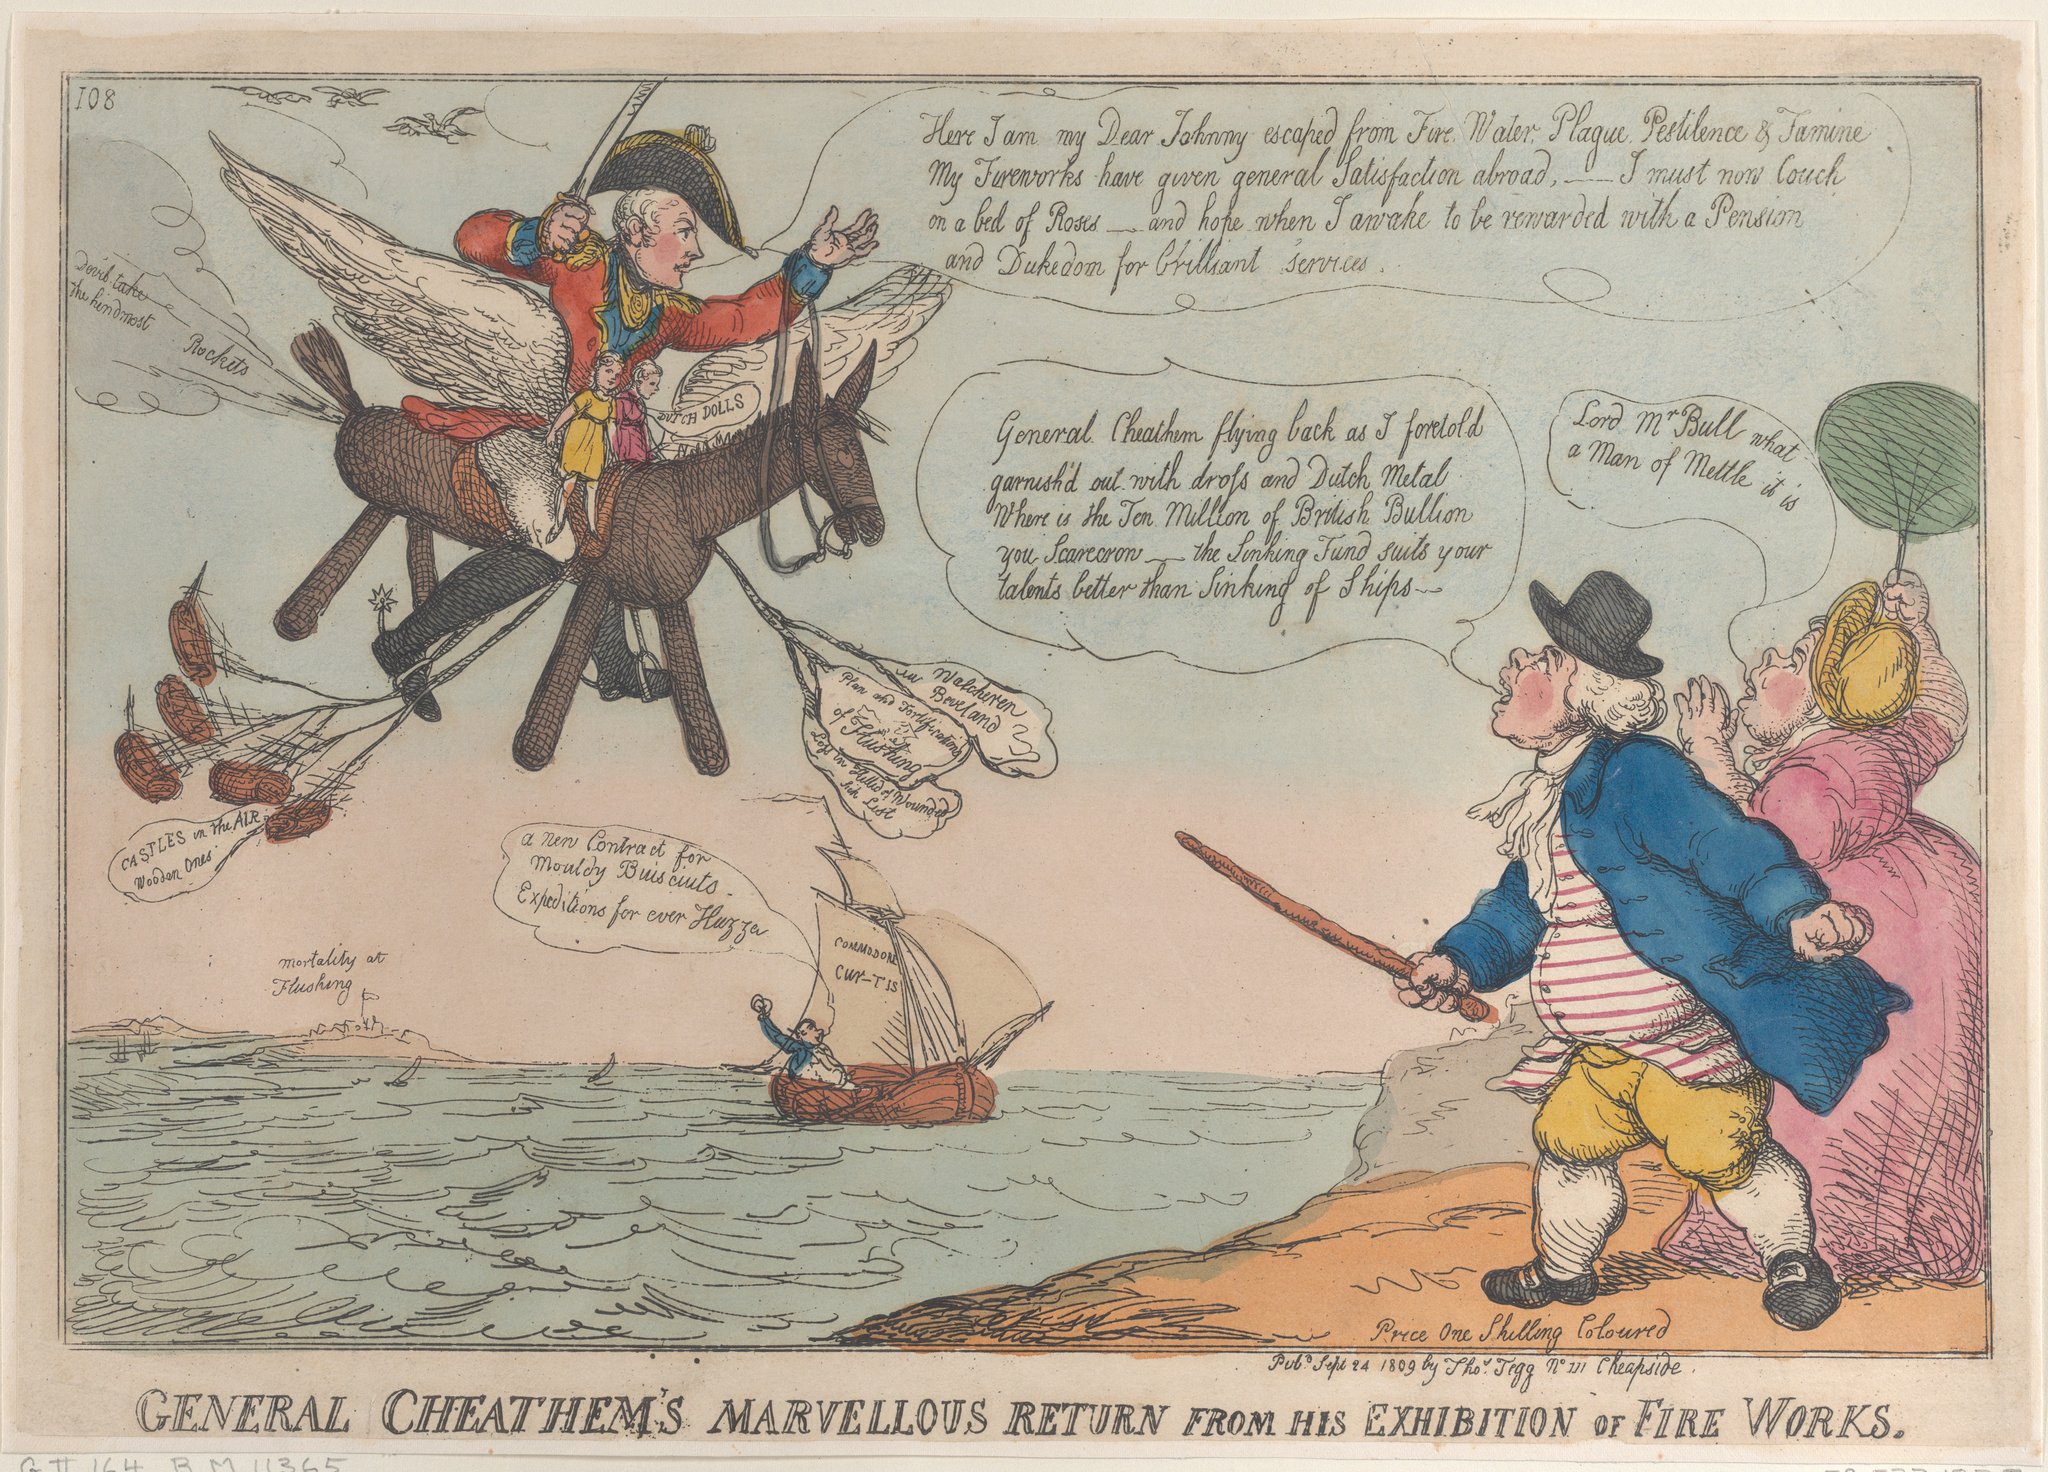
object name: print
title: General Cheathem's Marvellous Return from His Exhibition of Fire Works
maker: thomas rowlandson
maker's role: artist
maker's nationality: british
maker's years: 1757-1827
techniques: etching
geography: london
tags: satire,men,women,horses,ships,politics